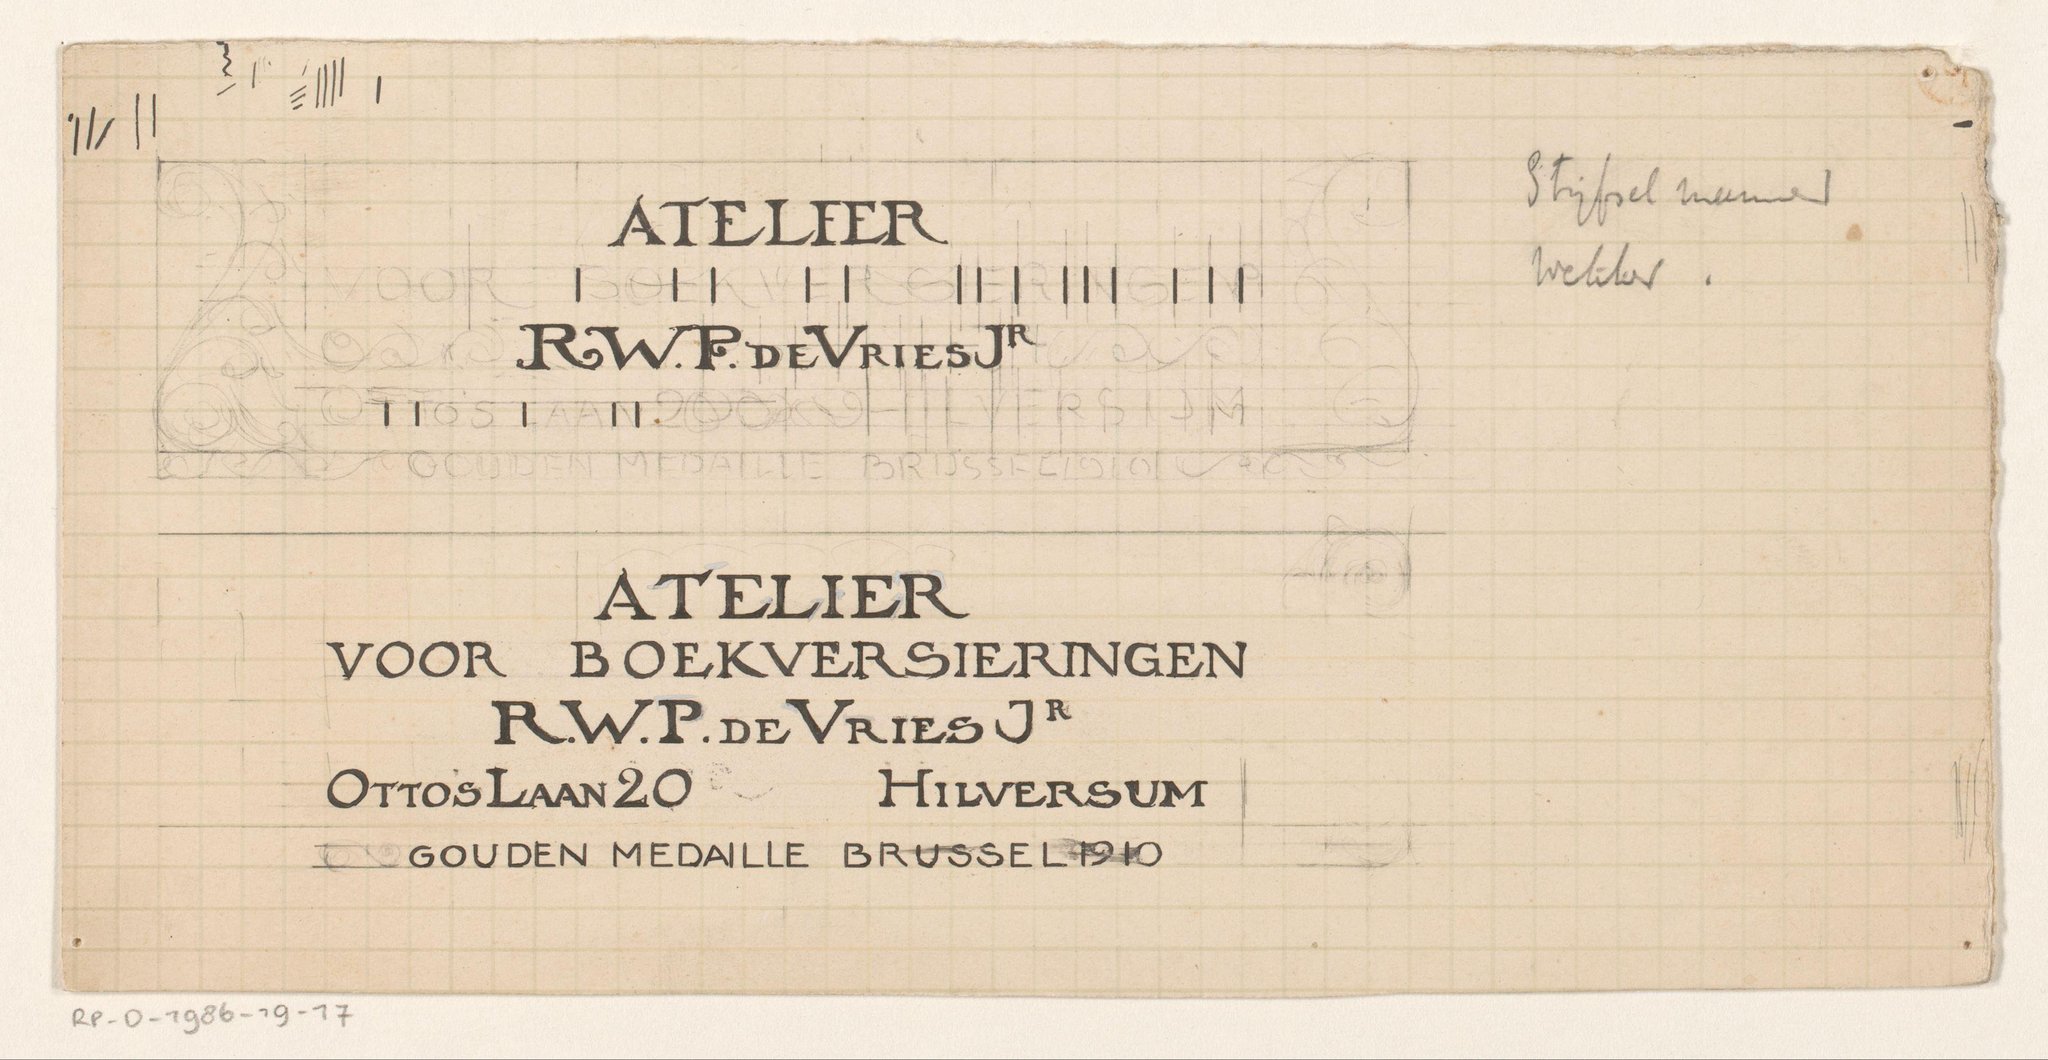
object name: design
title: Vignet van Atelier voor Boekversieringen te Hilversum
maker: reinier willem petrus de vries (1874-1953)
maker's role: draughtsman, print maker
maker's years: 1874-1953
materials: paint, ink, pencil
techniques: brush, pen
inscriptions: collector's mark: ‘R:MVS.’, annotation: ‘stijfsel mee[...]/ we[...]’